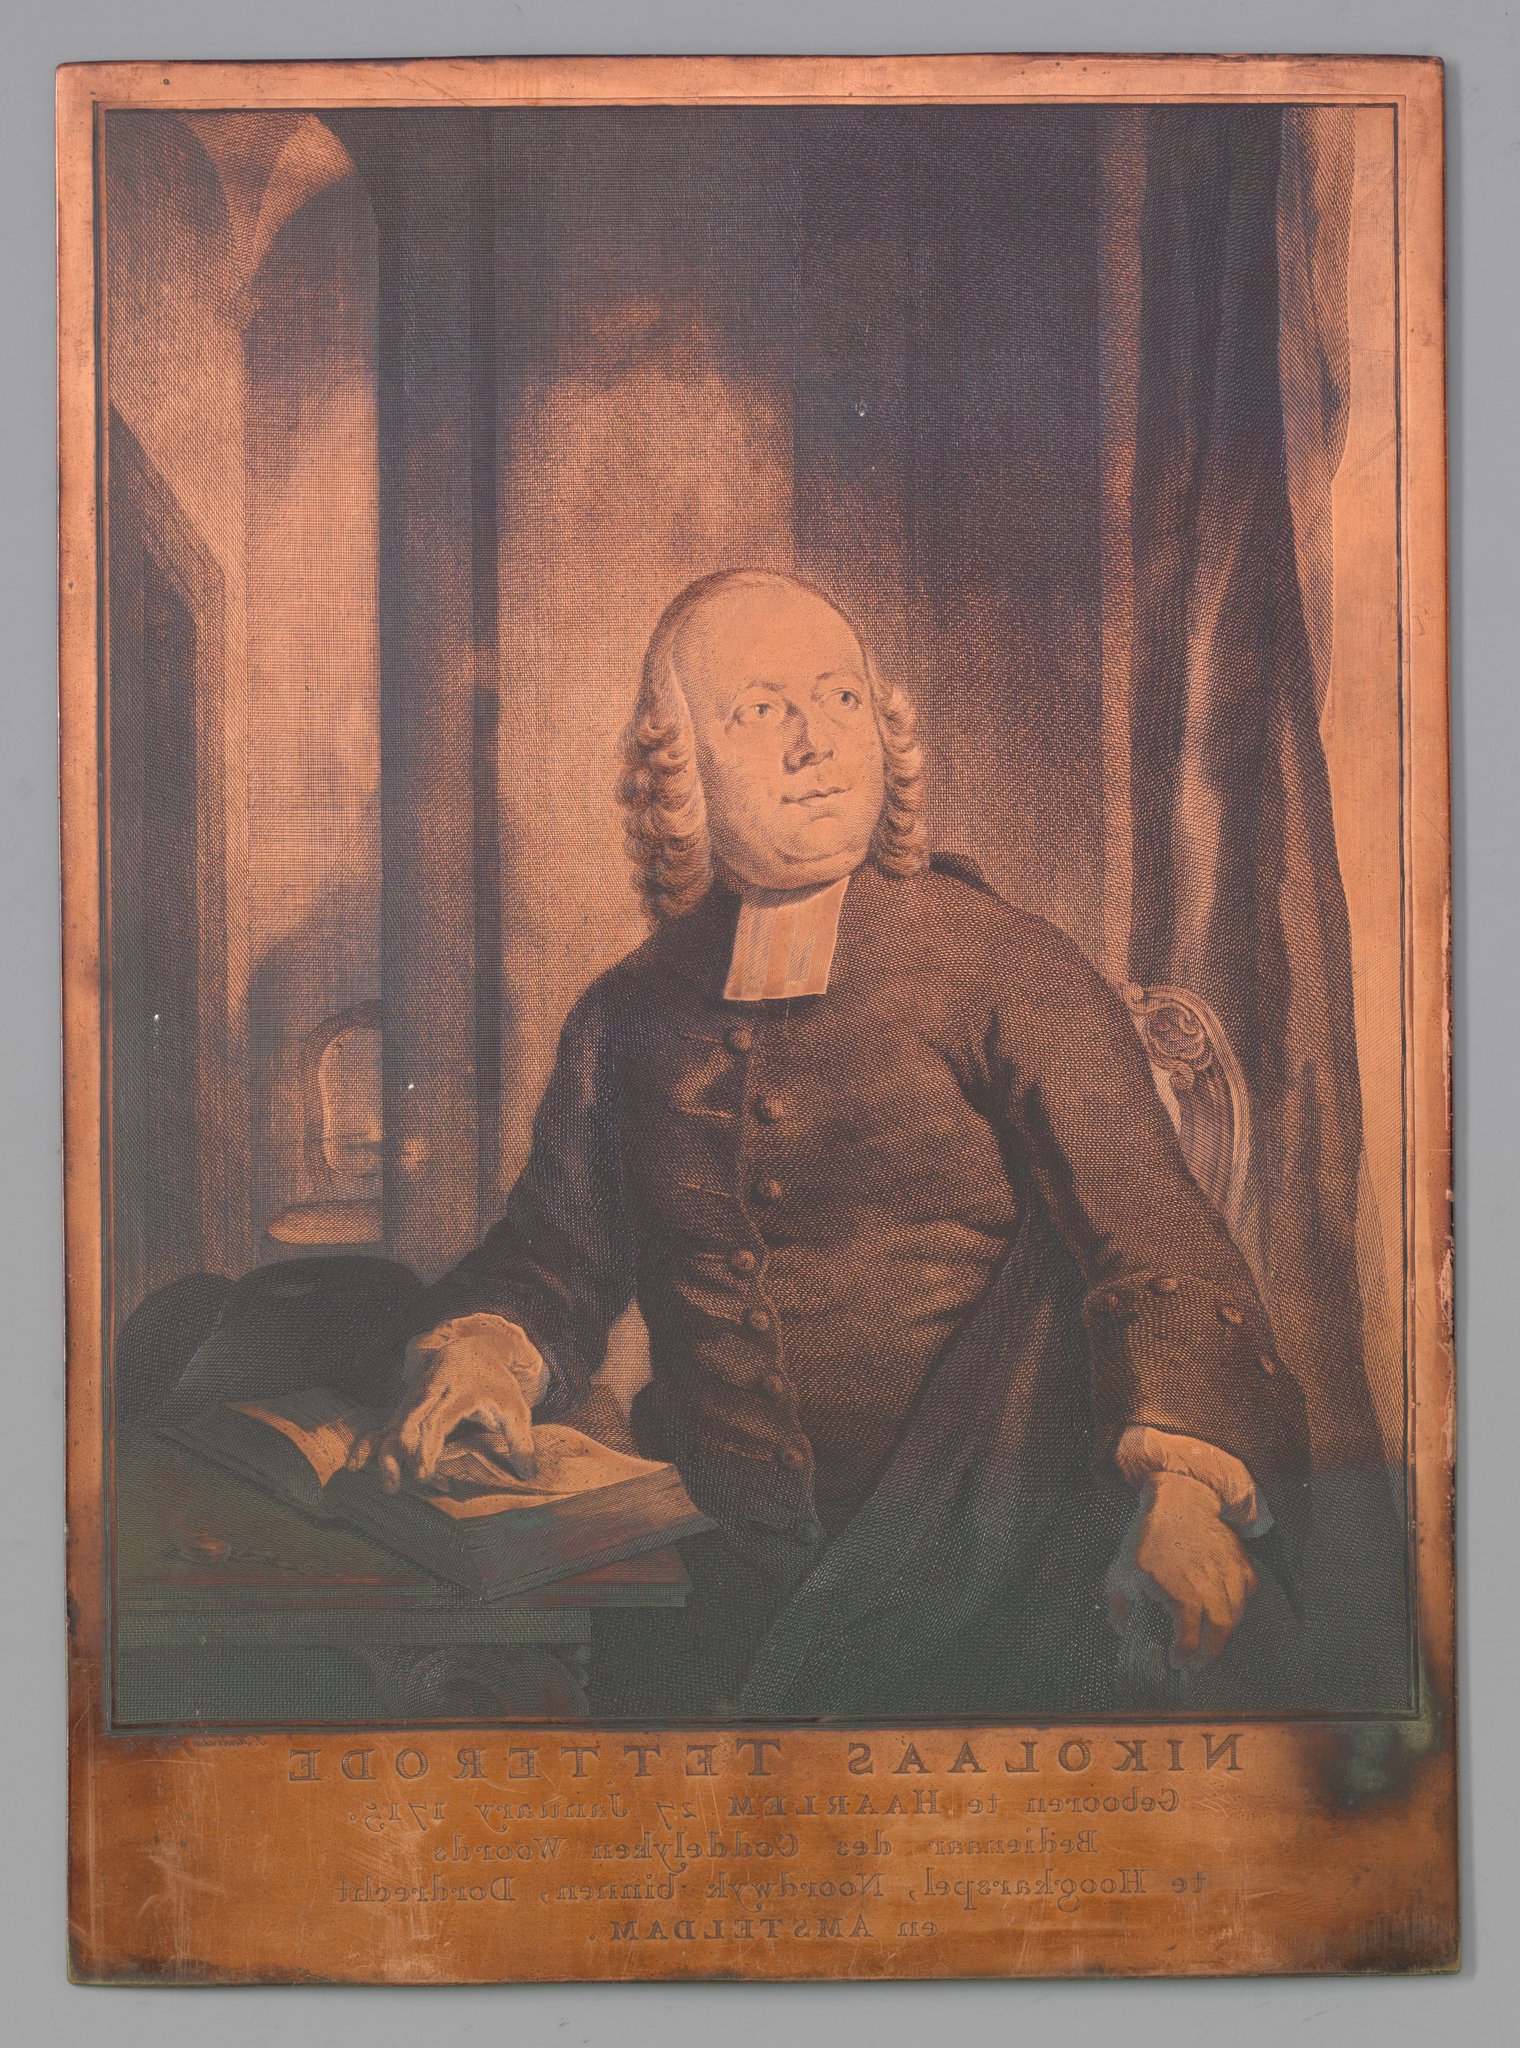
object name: copper plate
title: Nikolaas Tetterode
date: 1765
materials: copper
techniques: engraving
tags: amsterdam, historical persons, functionaries and dignitaries ~ episcopal protestant churches, book